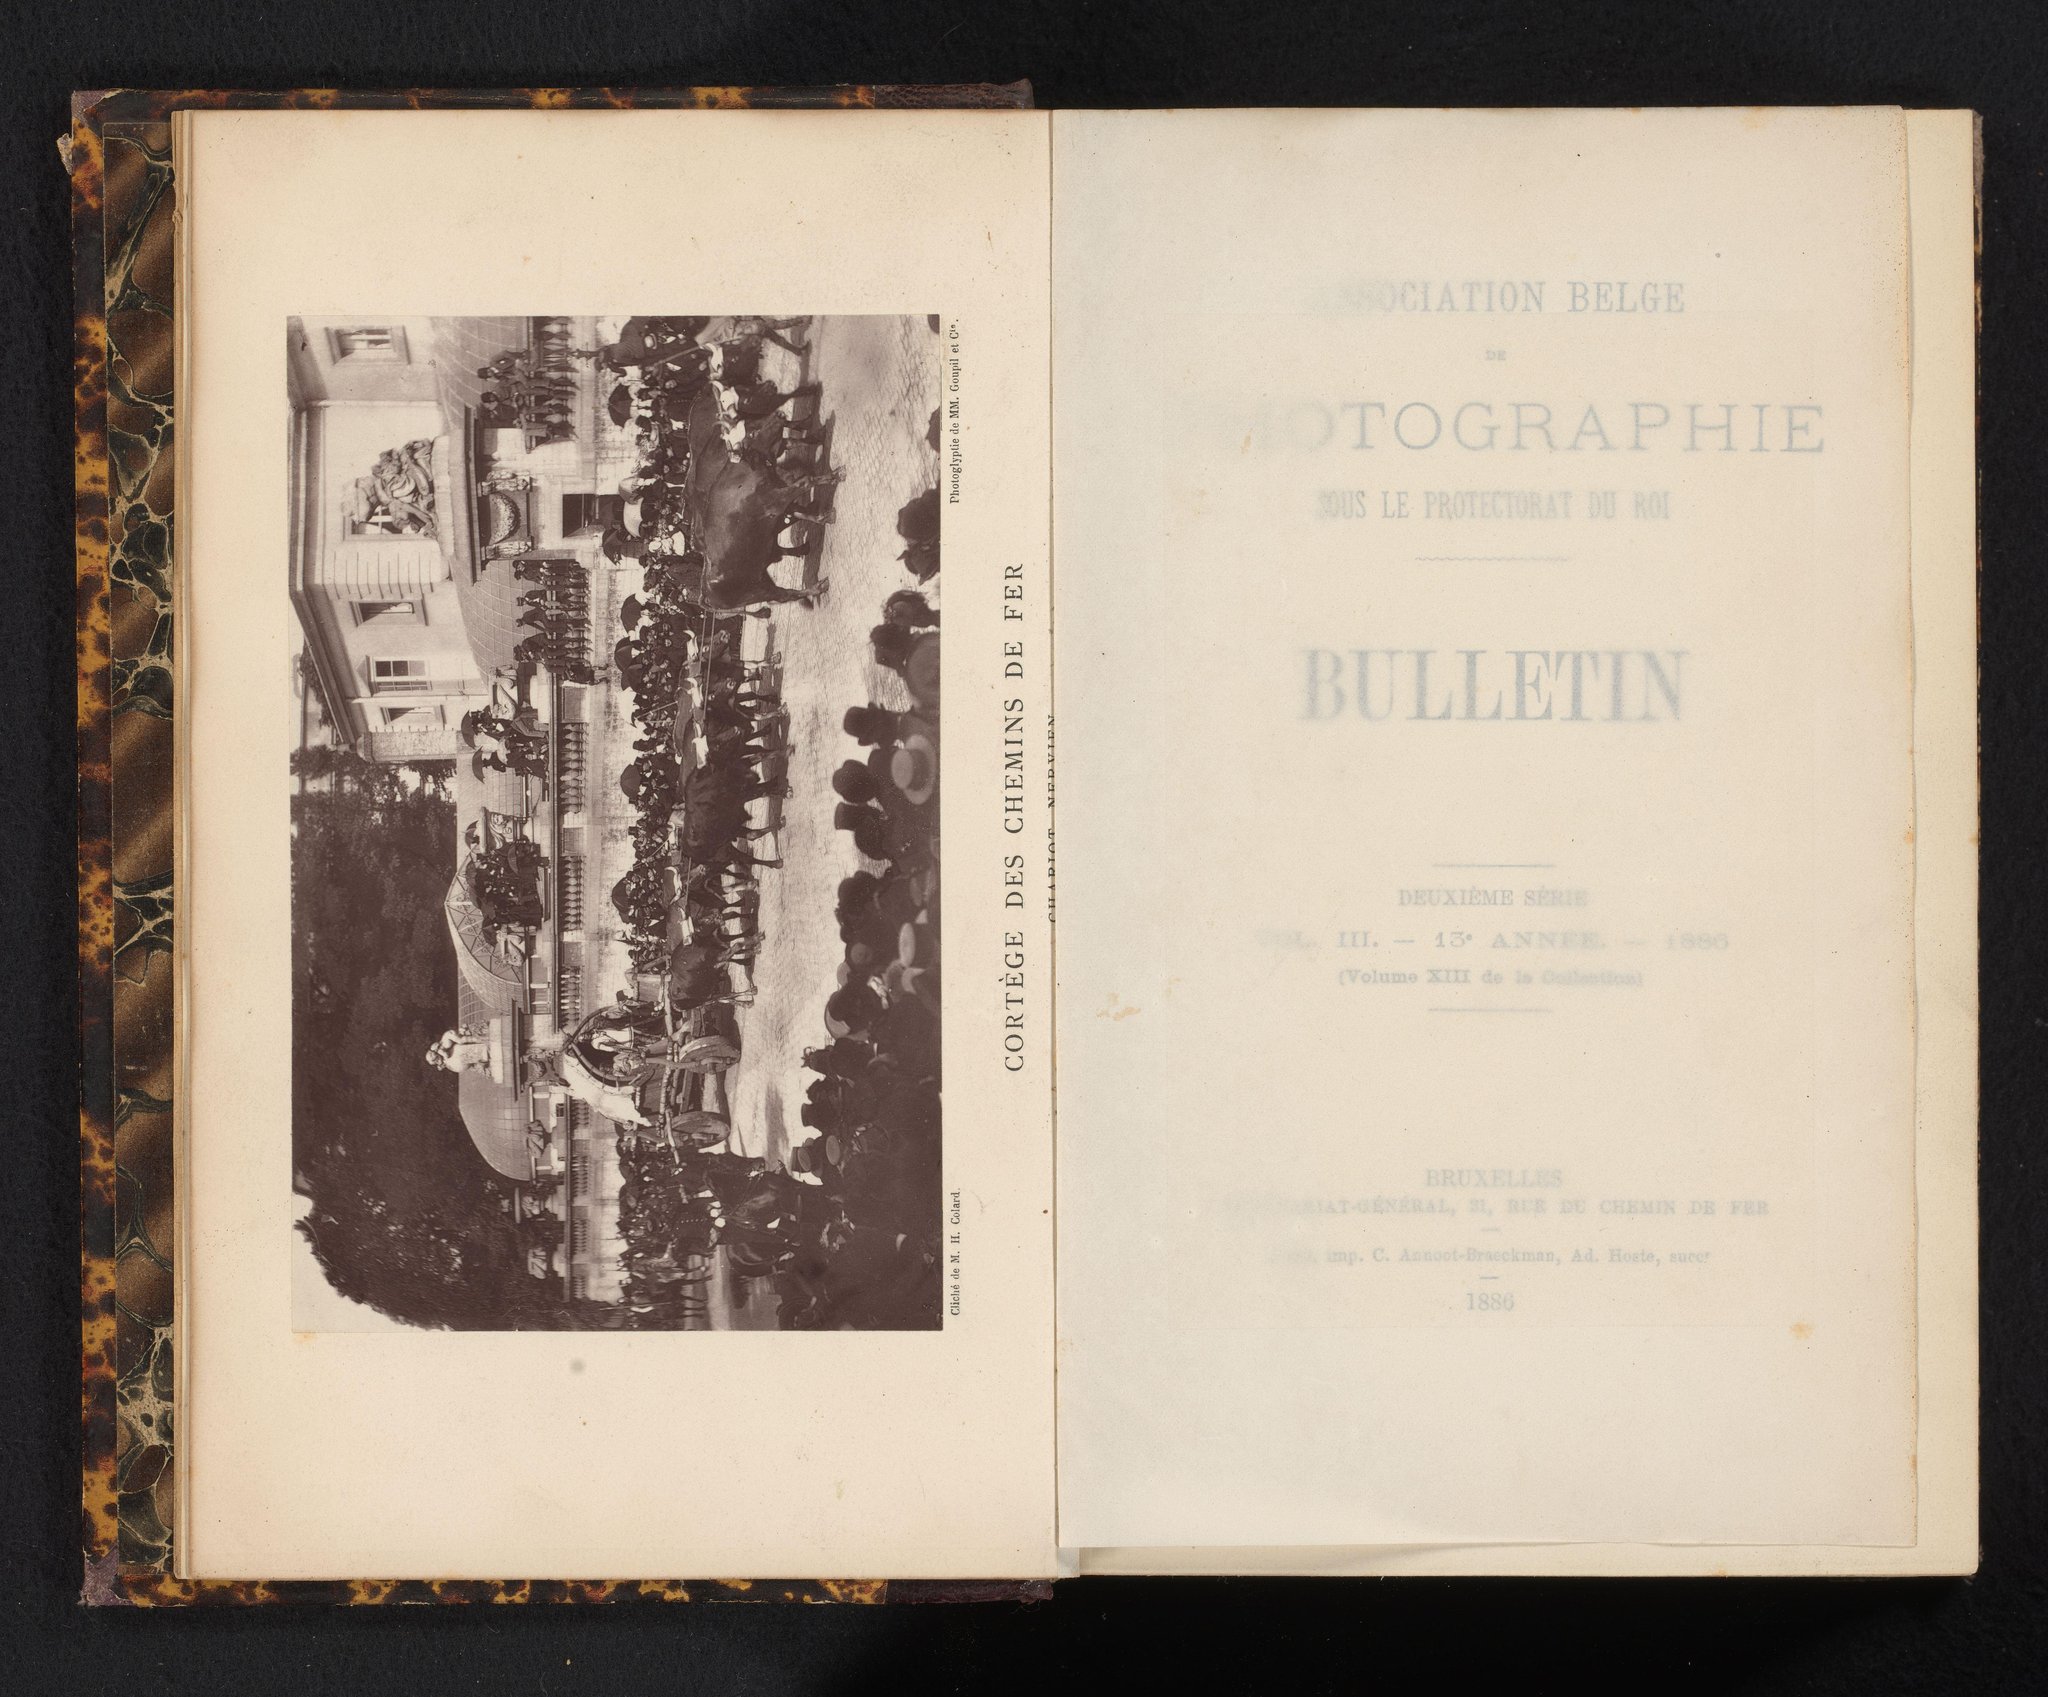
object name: photomechanical print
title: Cortège des chemins de fer, chariot Nervien (Bruxelles 1885)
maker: hector colard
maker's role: fotograaf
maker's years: 1851-1923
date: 1885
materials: paper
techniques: woodburytype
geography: brussels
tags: festivities ~ corporative organization, guild, public festivities, four-wheeled vehicle drawn by more than three animals, brussels